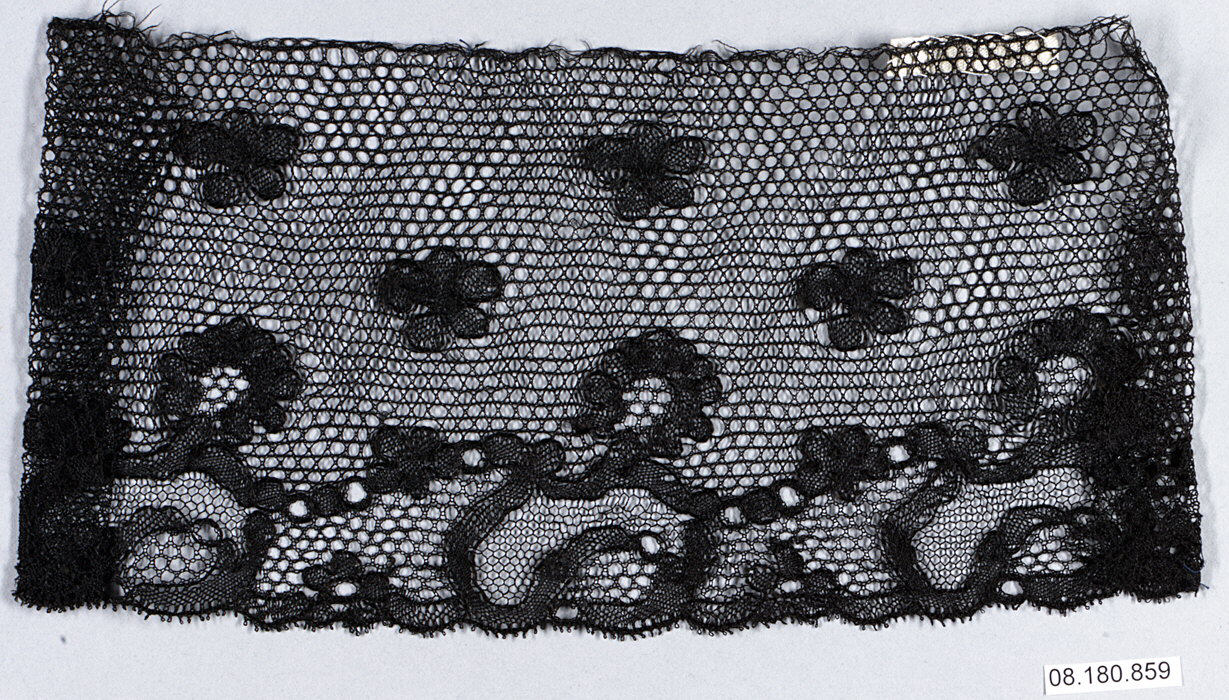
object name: piece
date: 1801-1900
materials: silk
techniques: lace